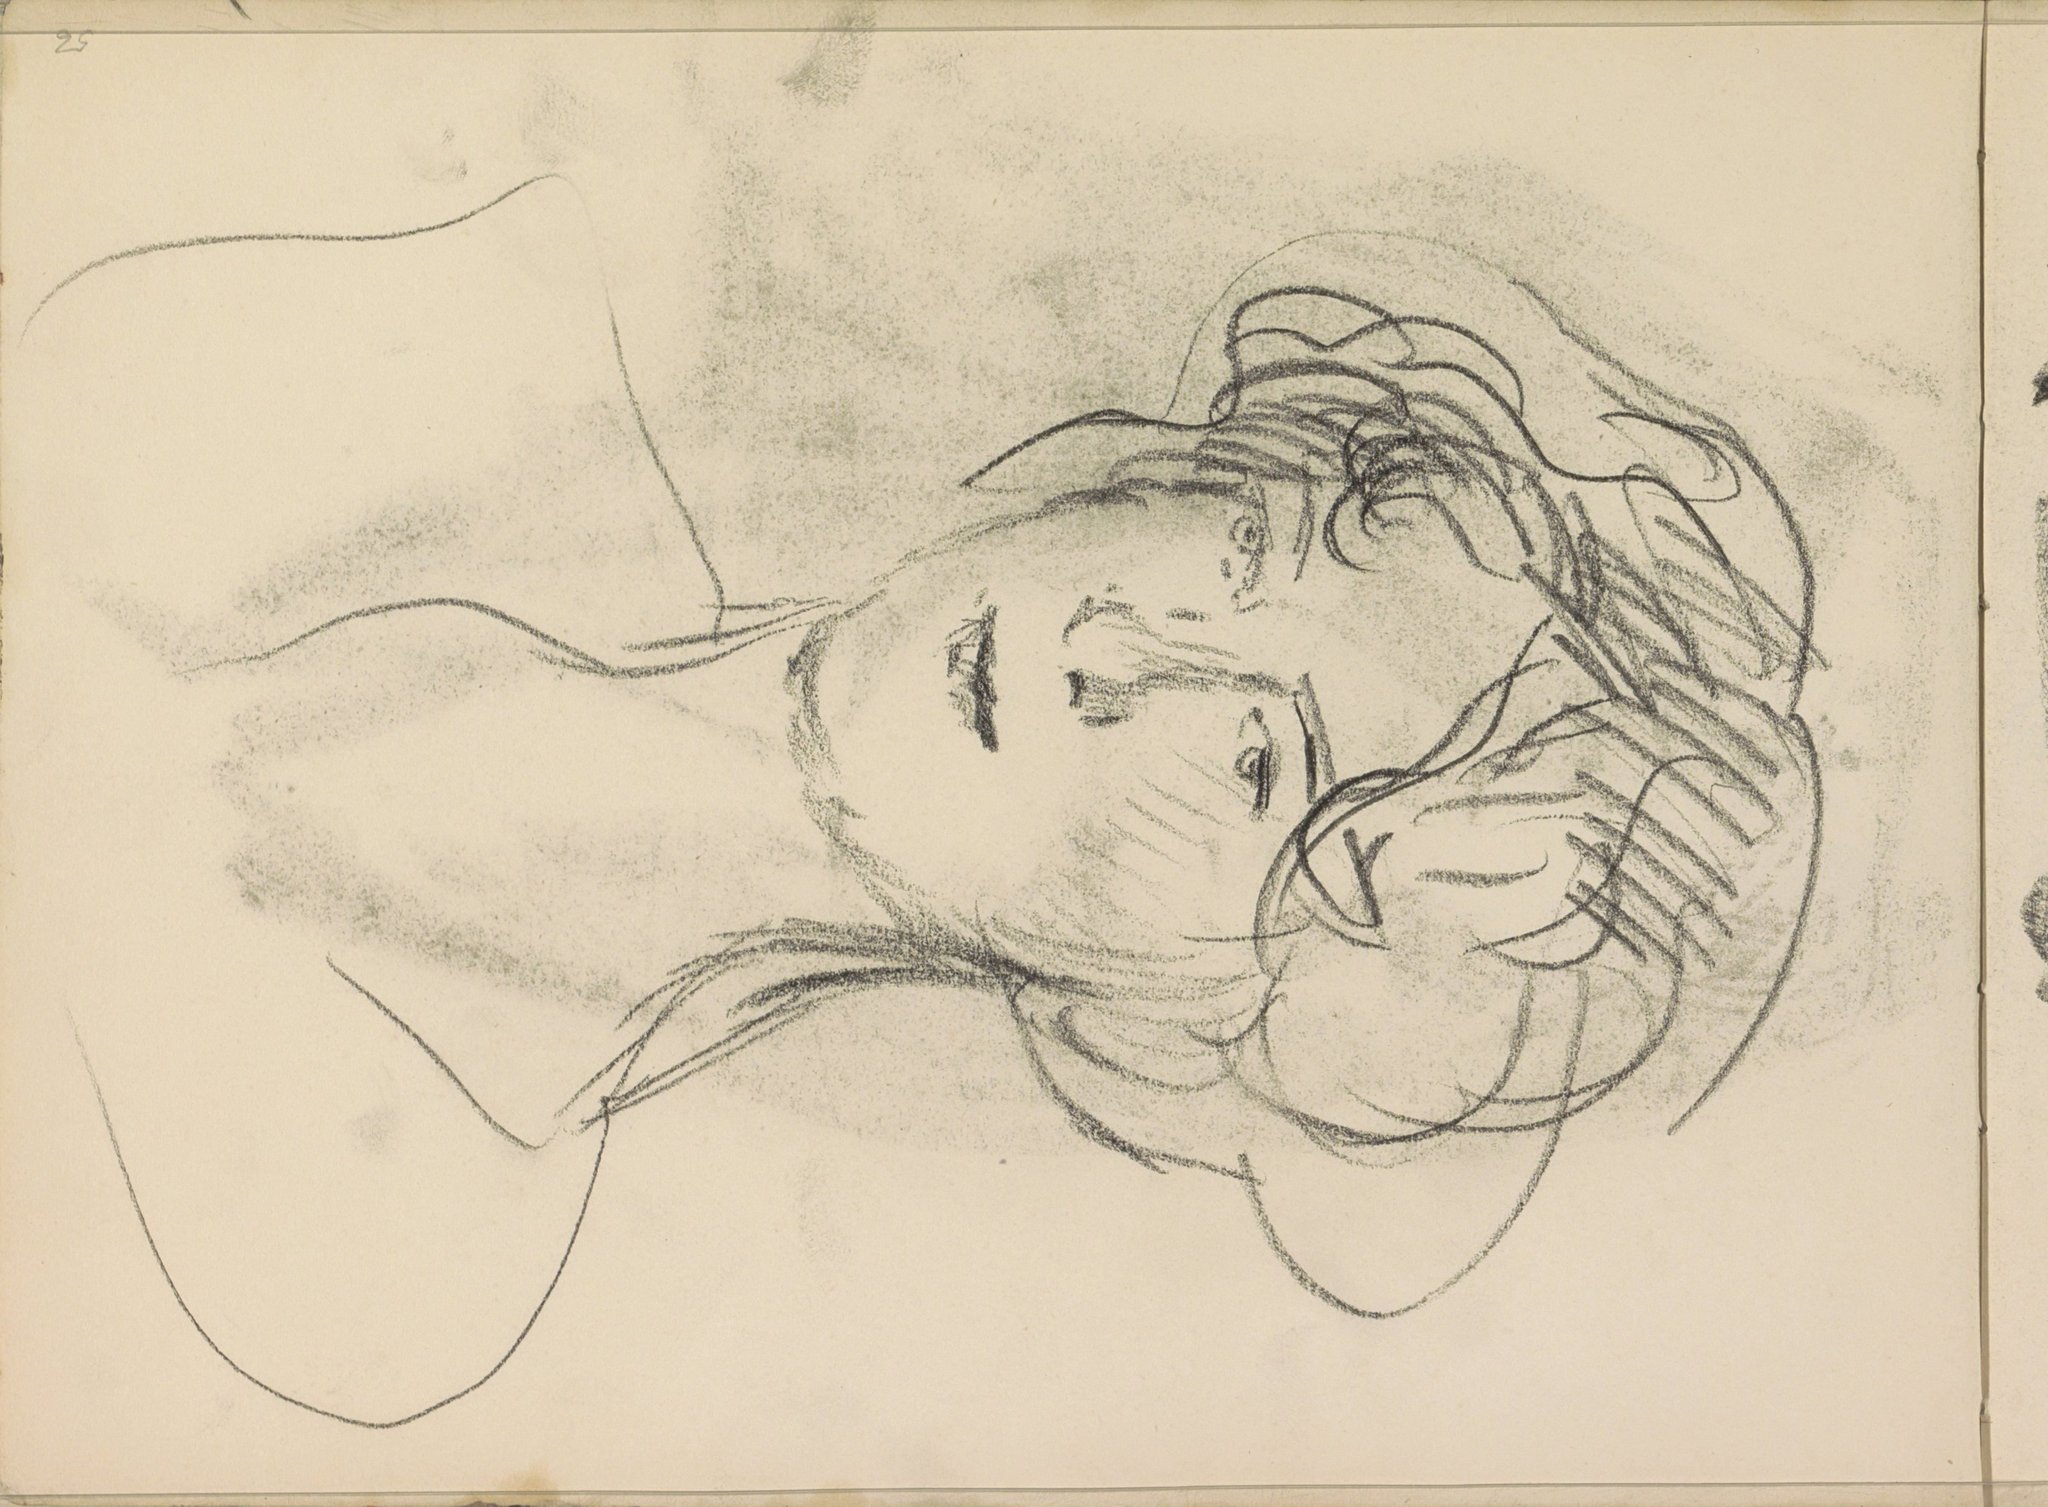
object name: sketchbook leaf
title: Portret van een onbekende vrouw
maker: isaac israels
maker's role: draughtsman, painter, print maker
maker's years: 1865-1934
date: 1890-1920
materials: chalk, paper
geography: the hague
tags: anonymous historical person portrayed alone - bb - woman, head (human) - aa - female human figure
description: Blad 31 verso uit schetsboek X met 43 bladen.